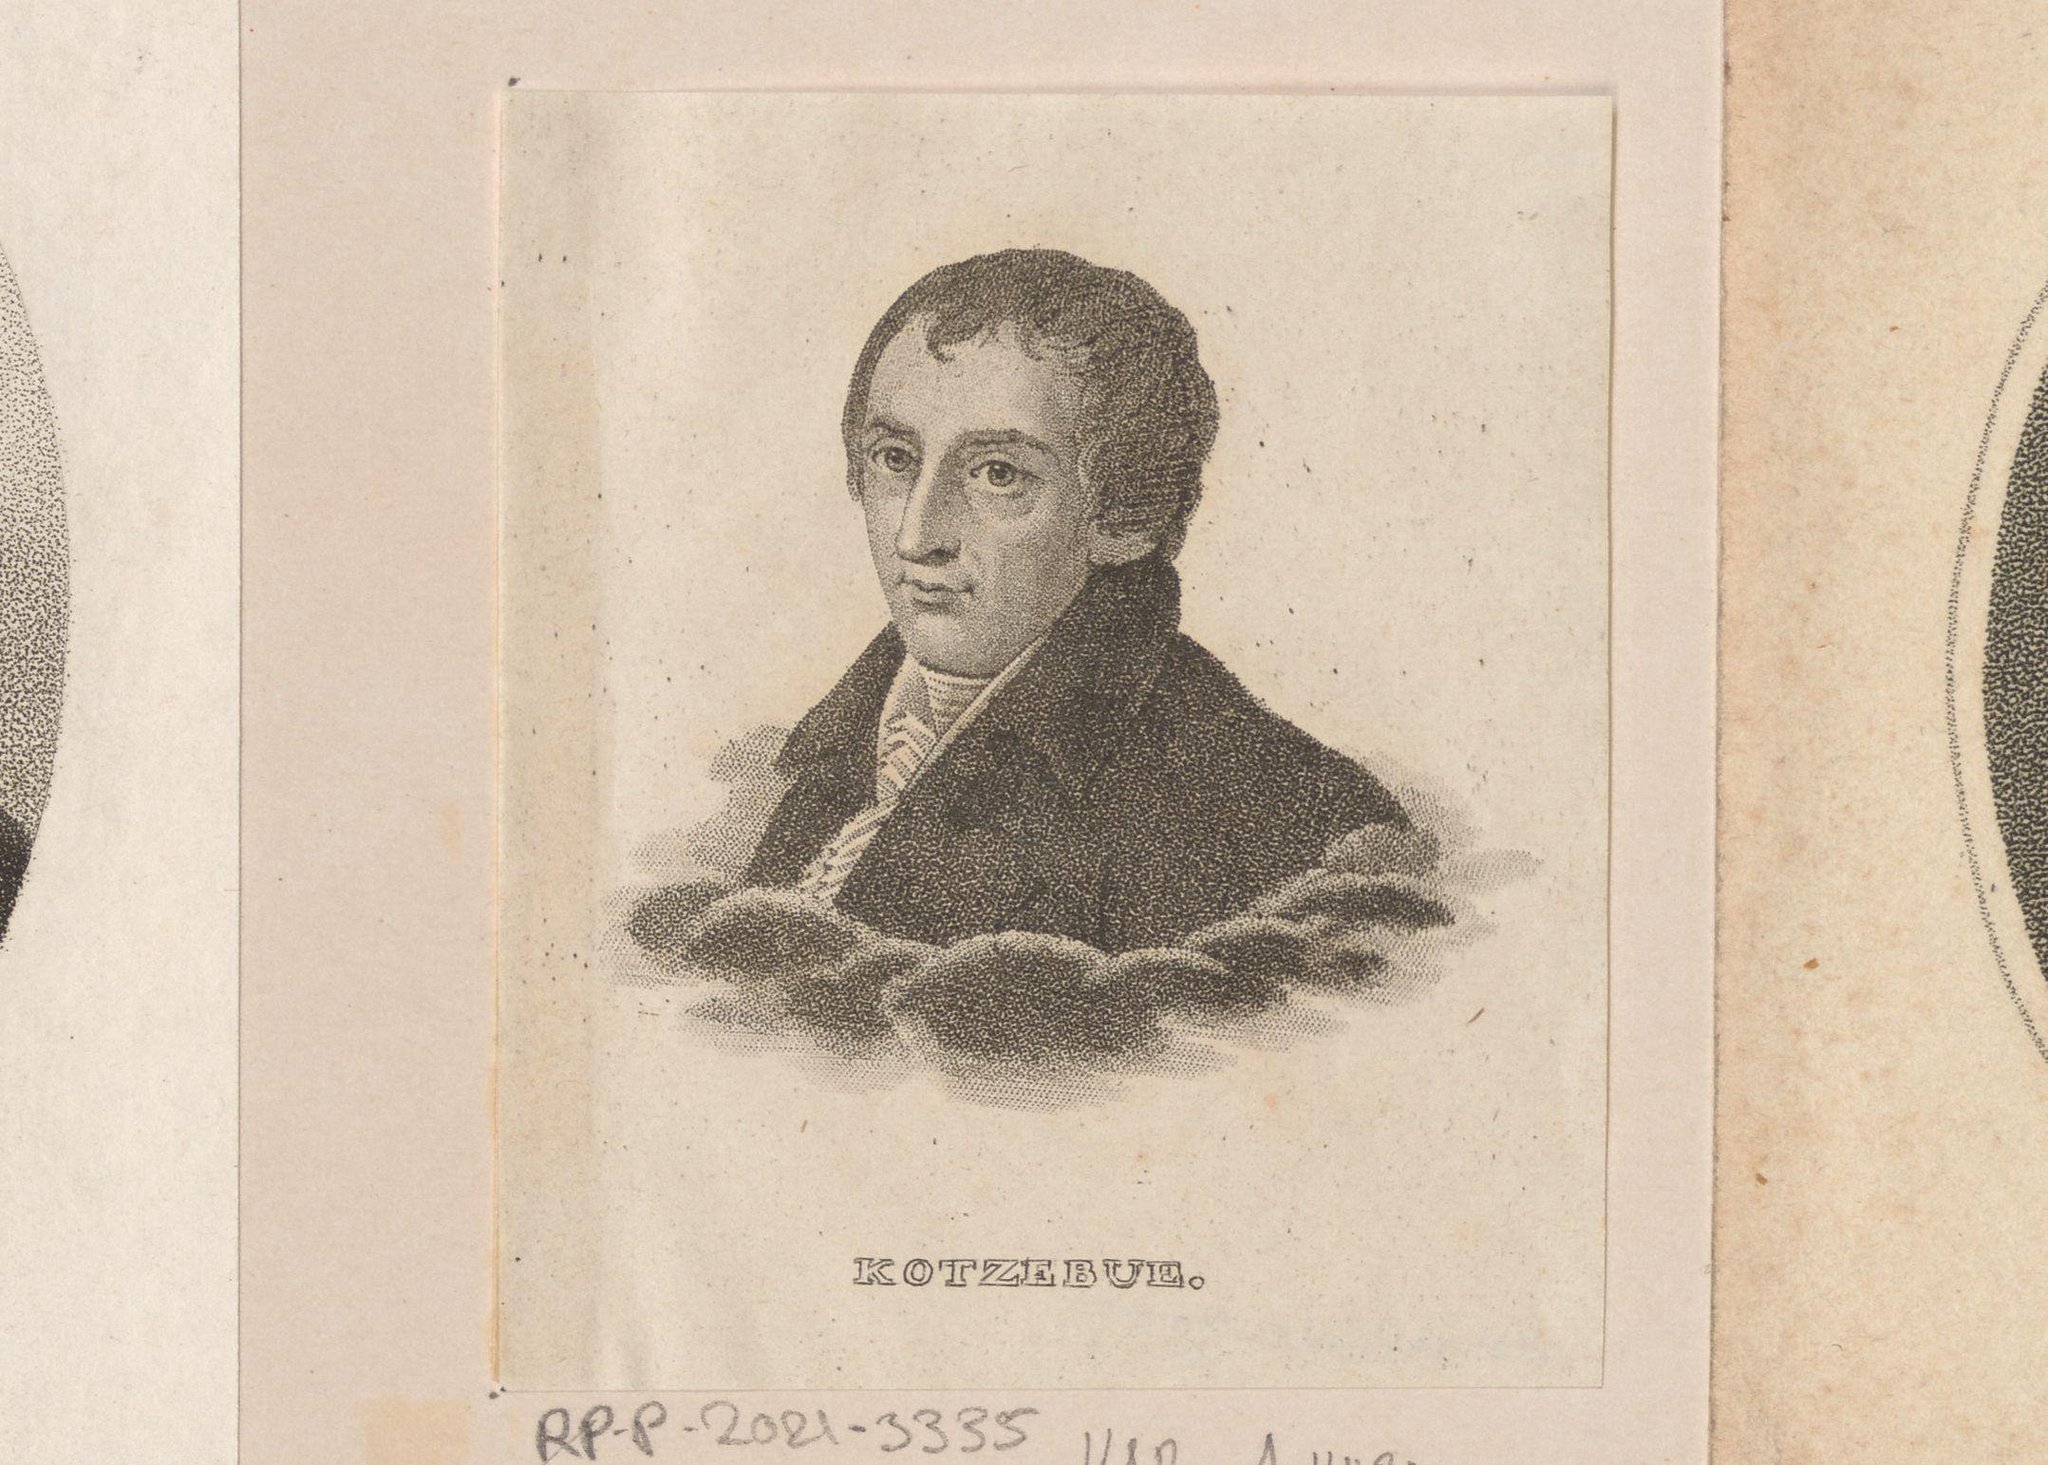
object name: print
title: Portret van August Friedrich Ferdinand von Kotzebue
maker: Anonymous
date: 1781-1849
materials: paper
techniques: engraving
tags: historical persons